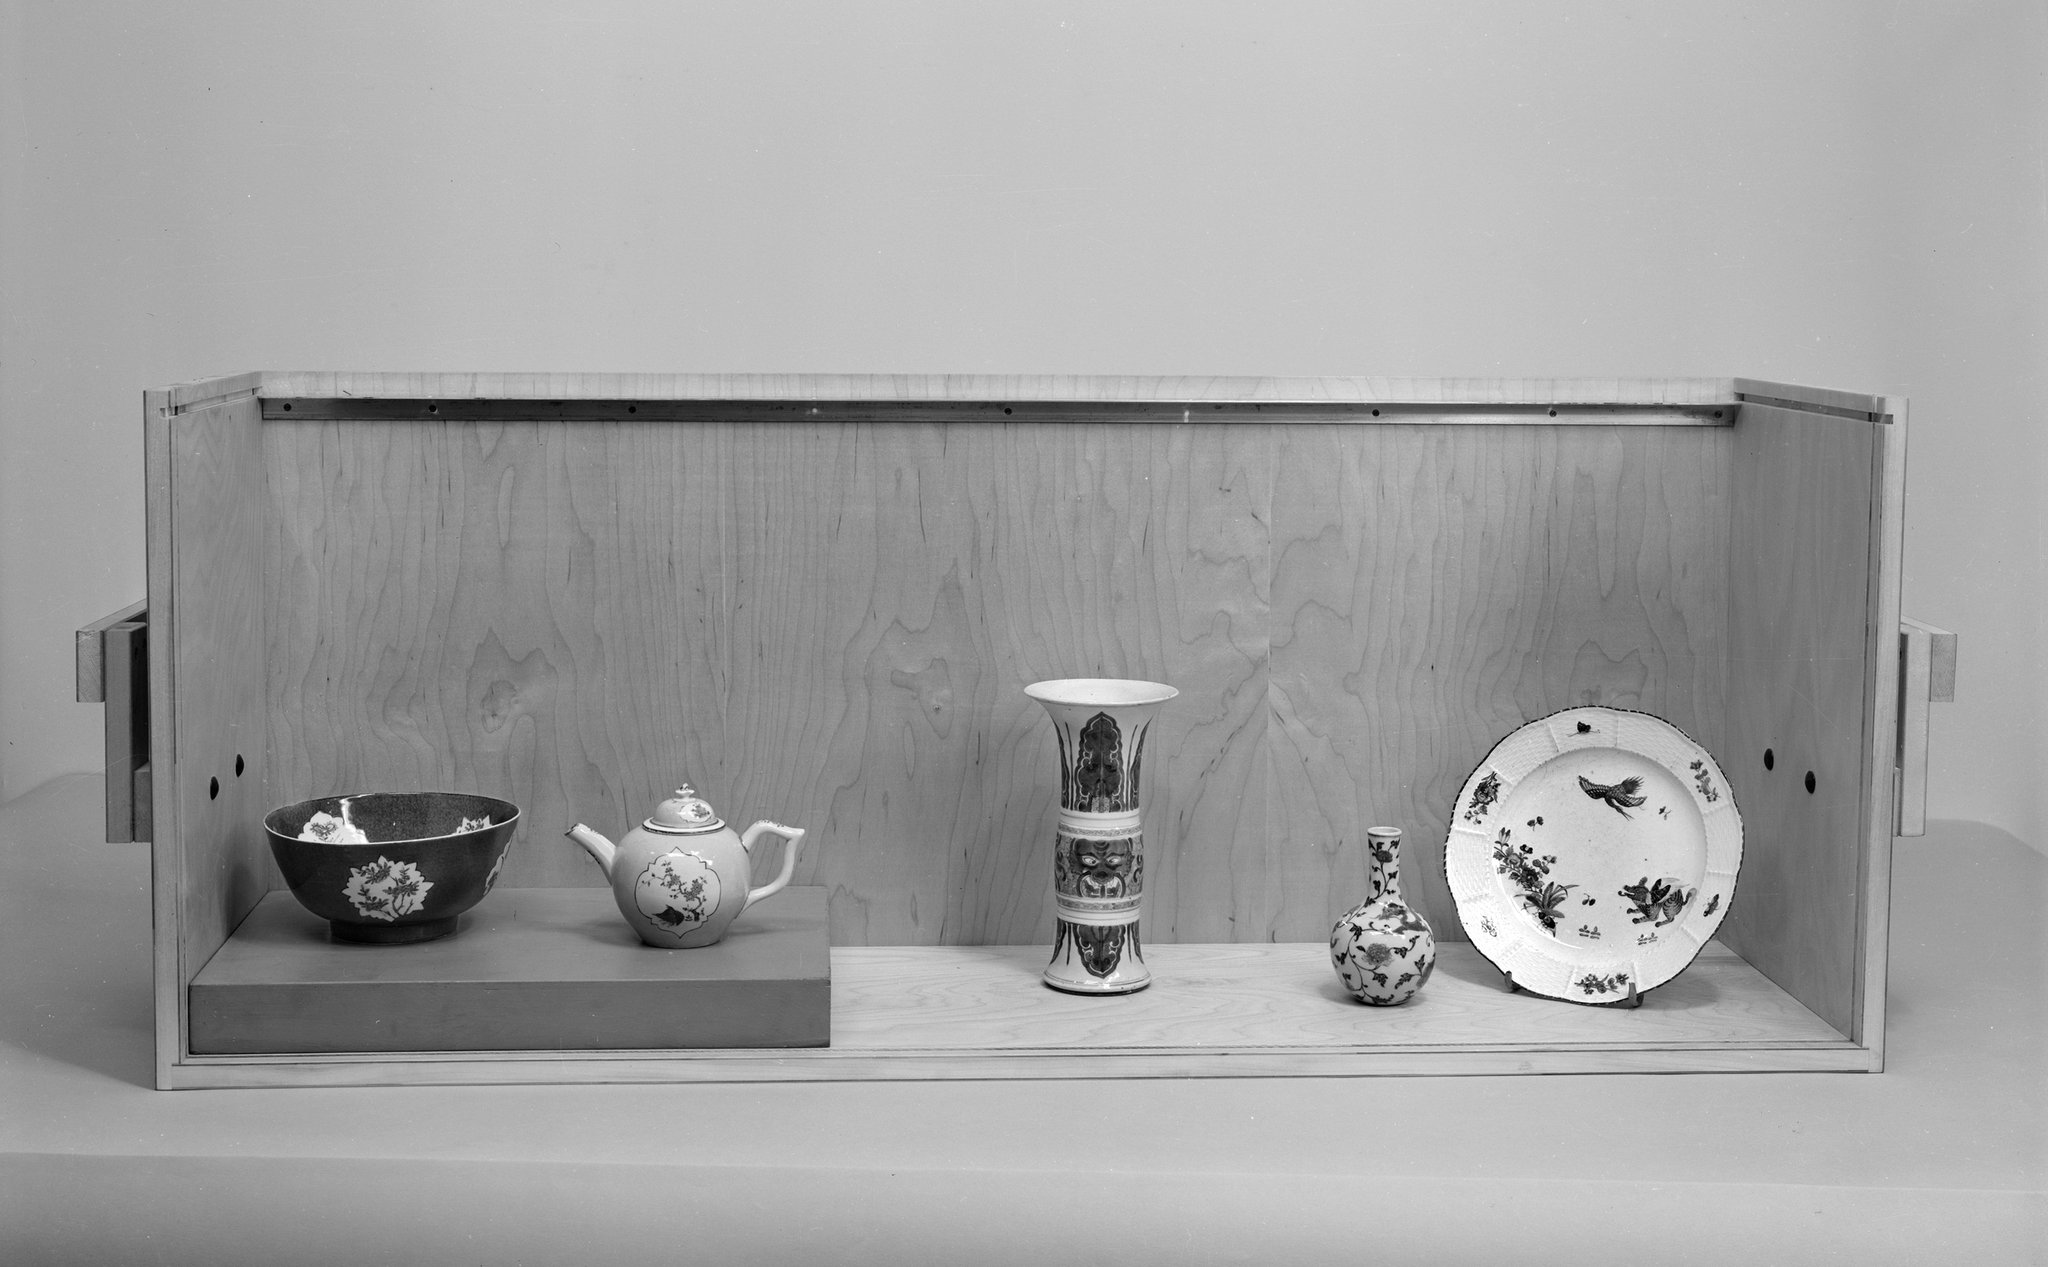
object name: bowl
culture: chinese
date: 1701-1733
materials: glaze, porcelain